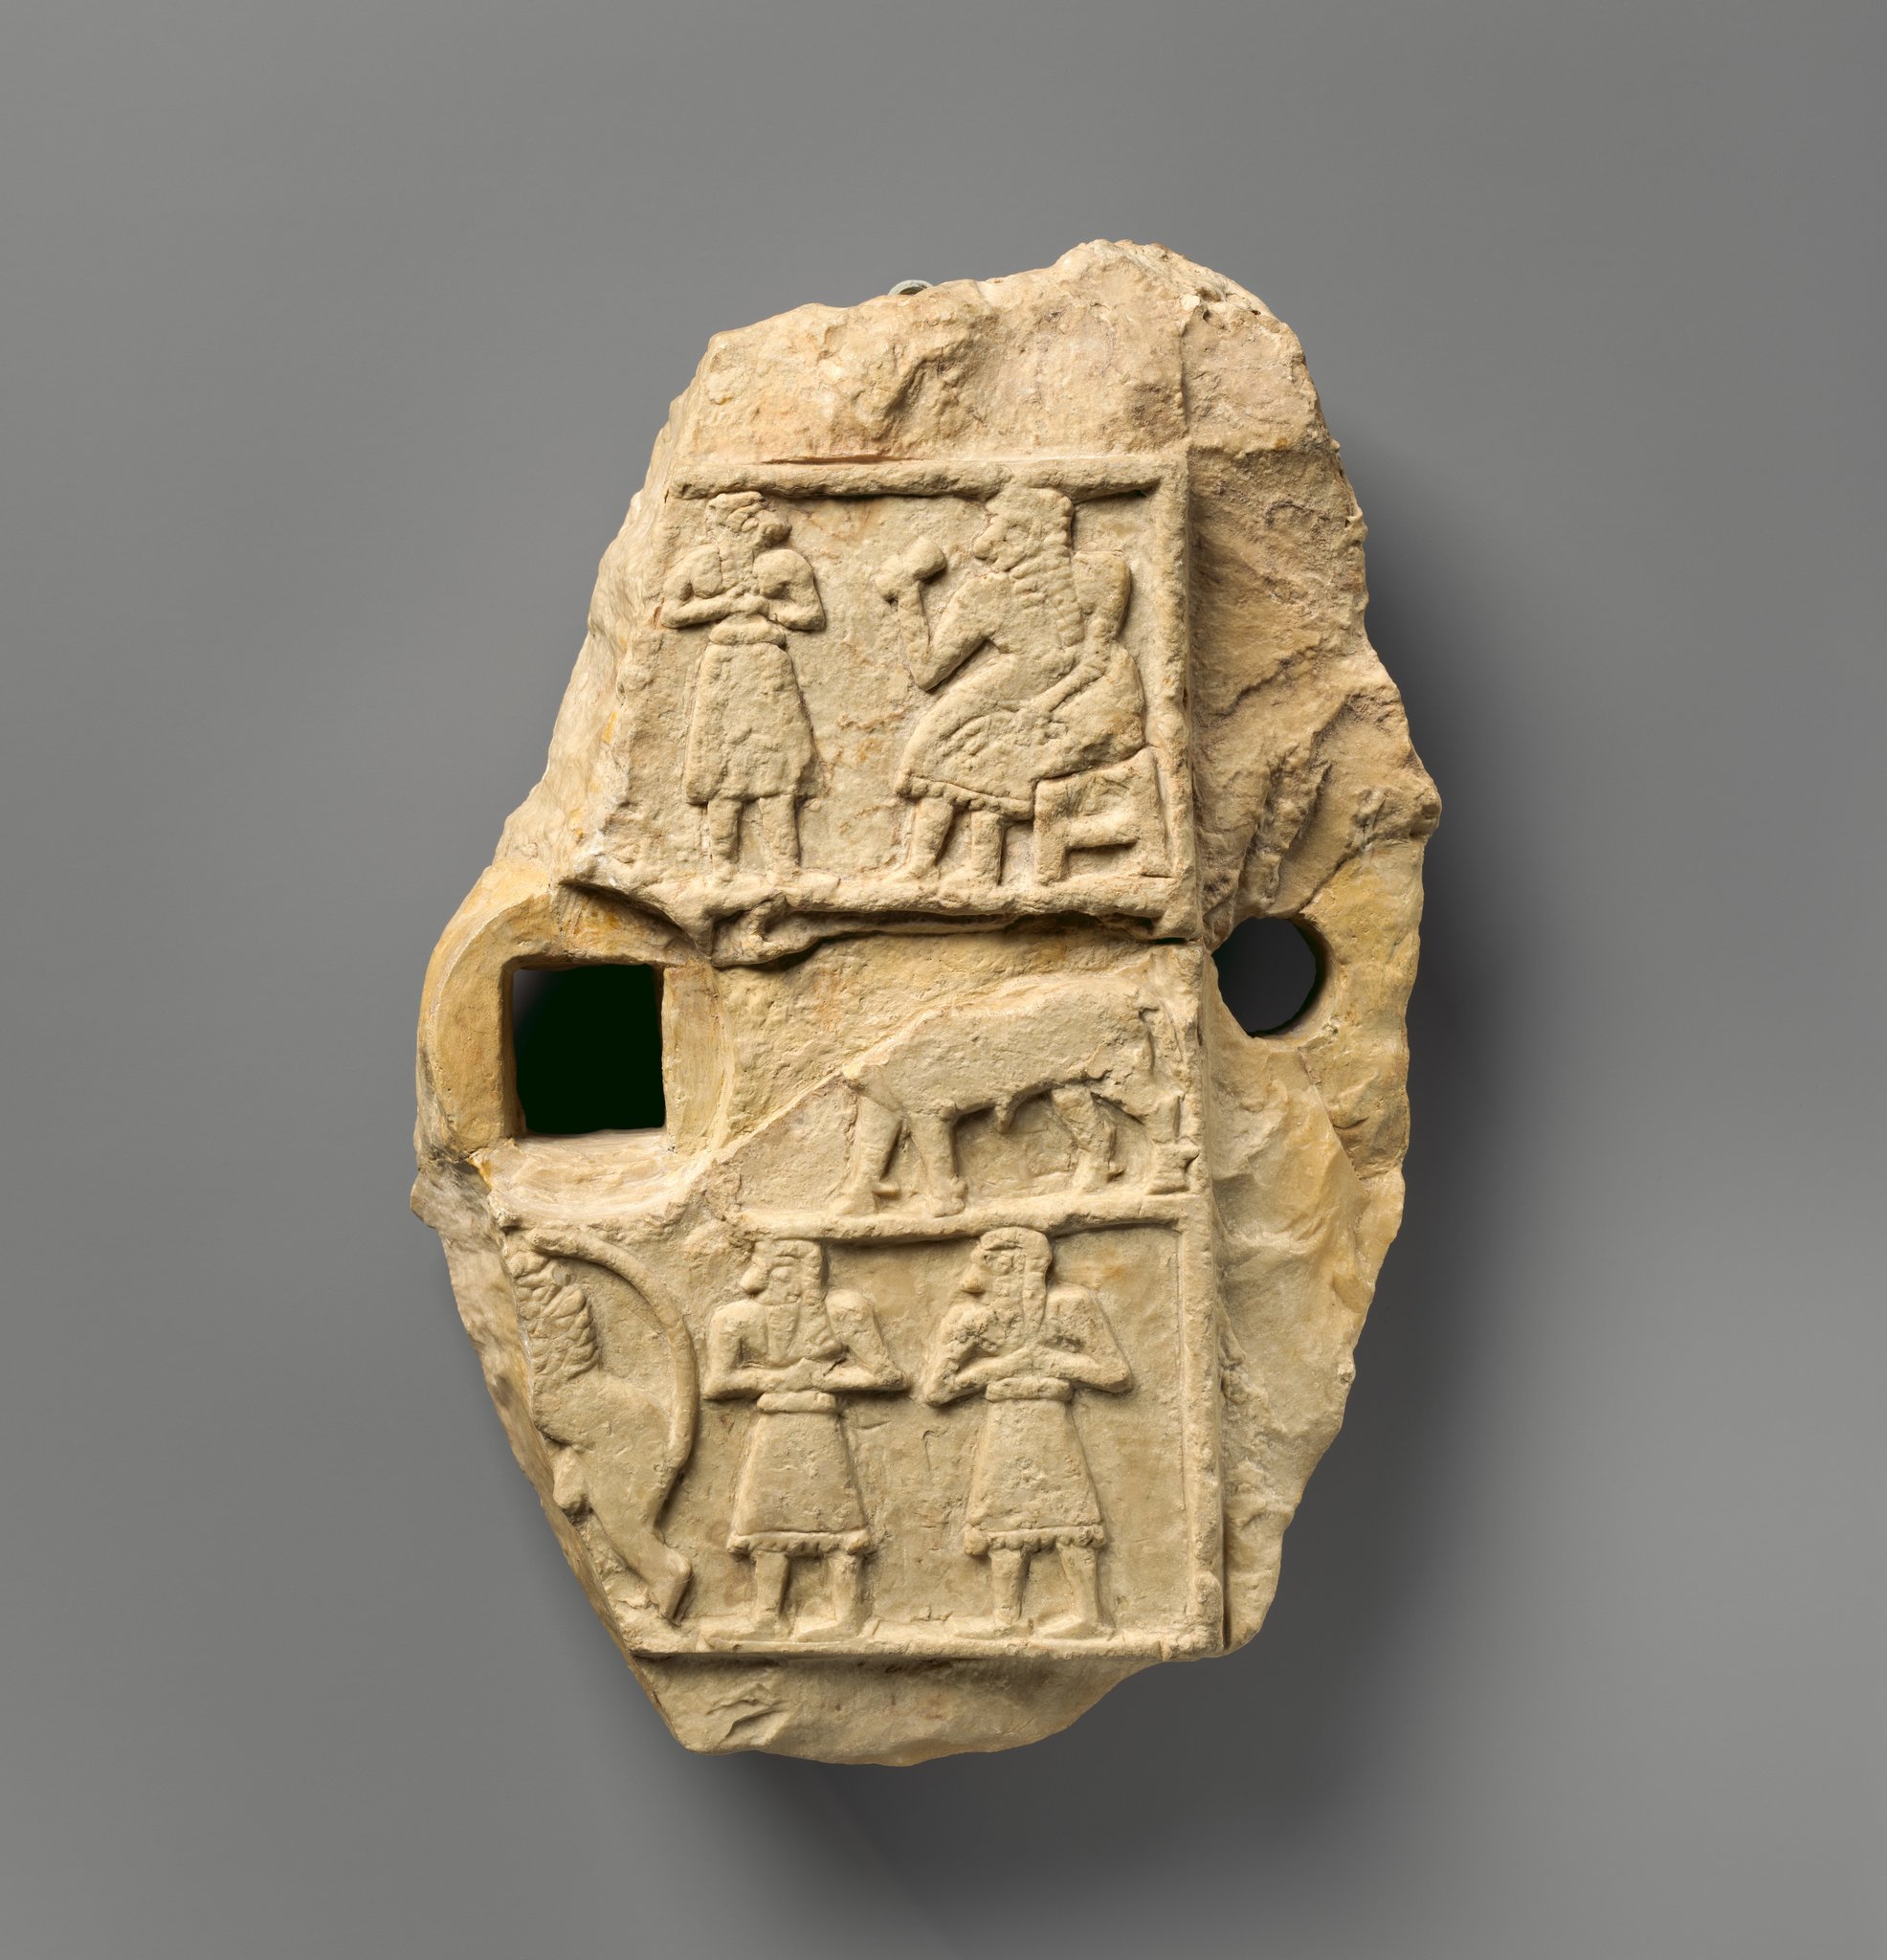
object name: relief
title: Relief plaque with a banquet scene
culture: sumerian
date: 2600-2500 BCE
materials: alabaster, gypsum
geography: mesopotamia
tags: animals,banquets